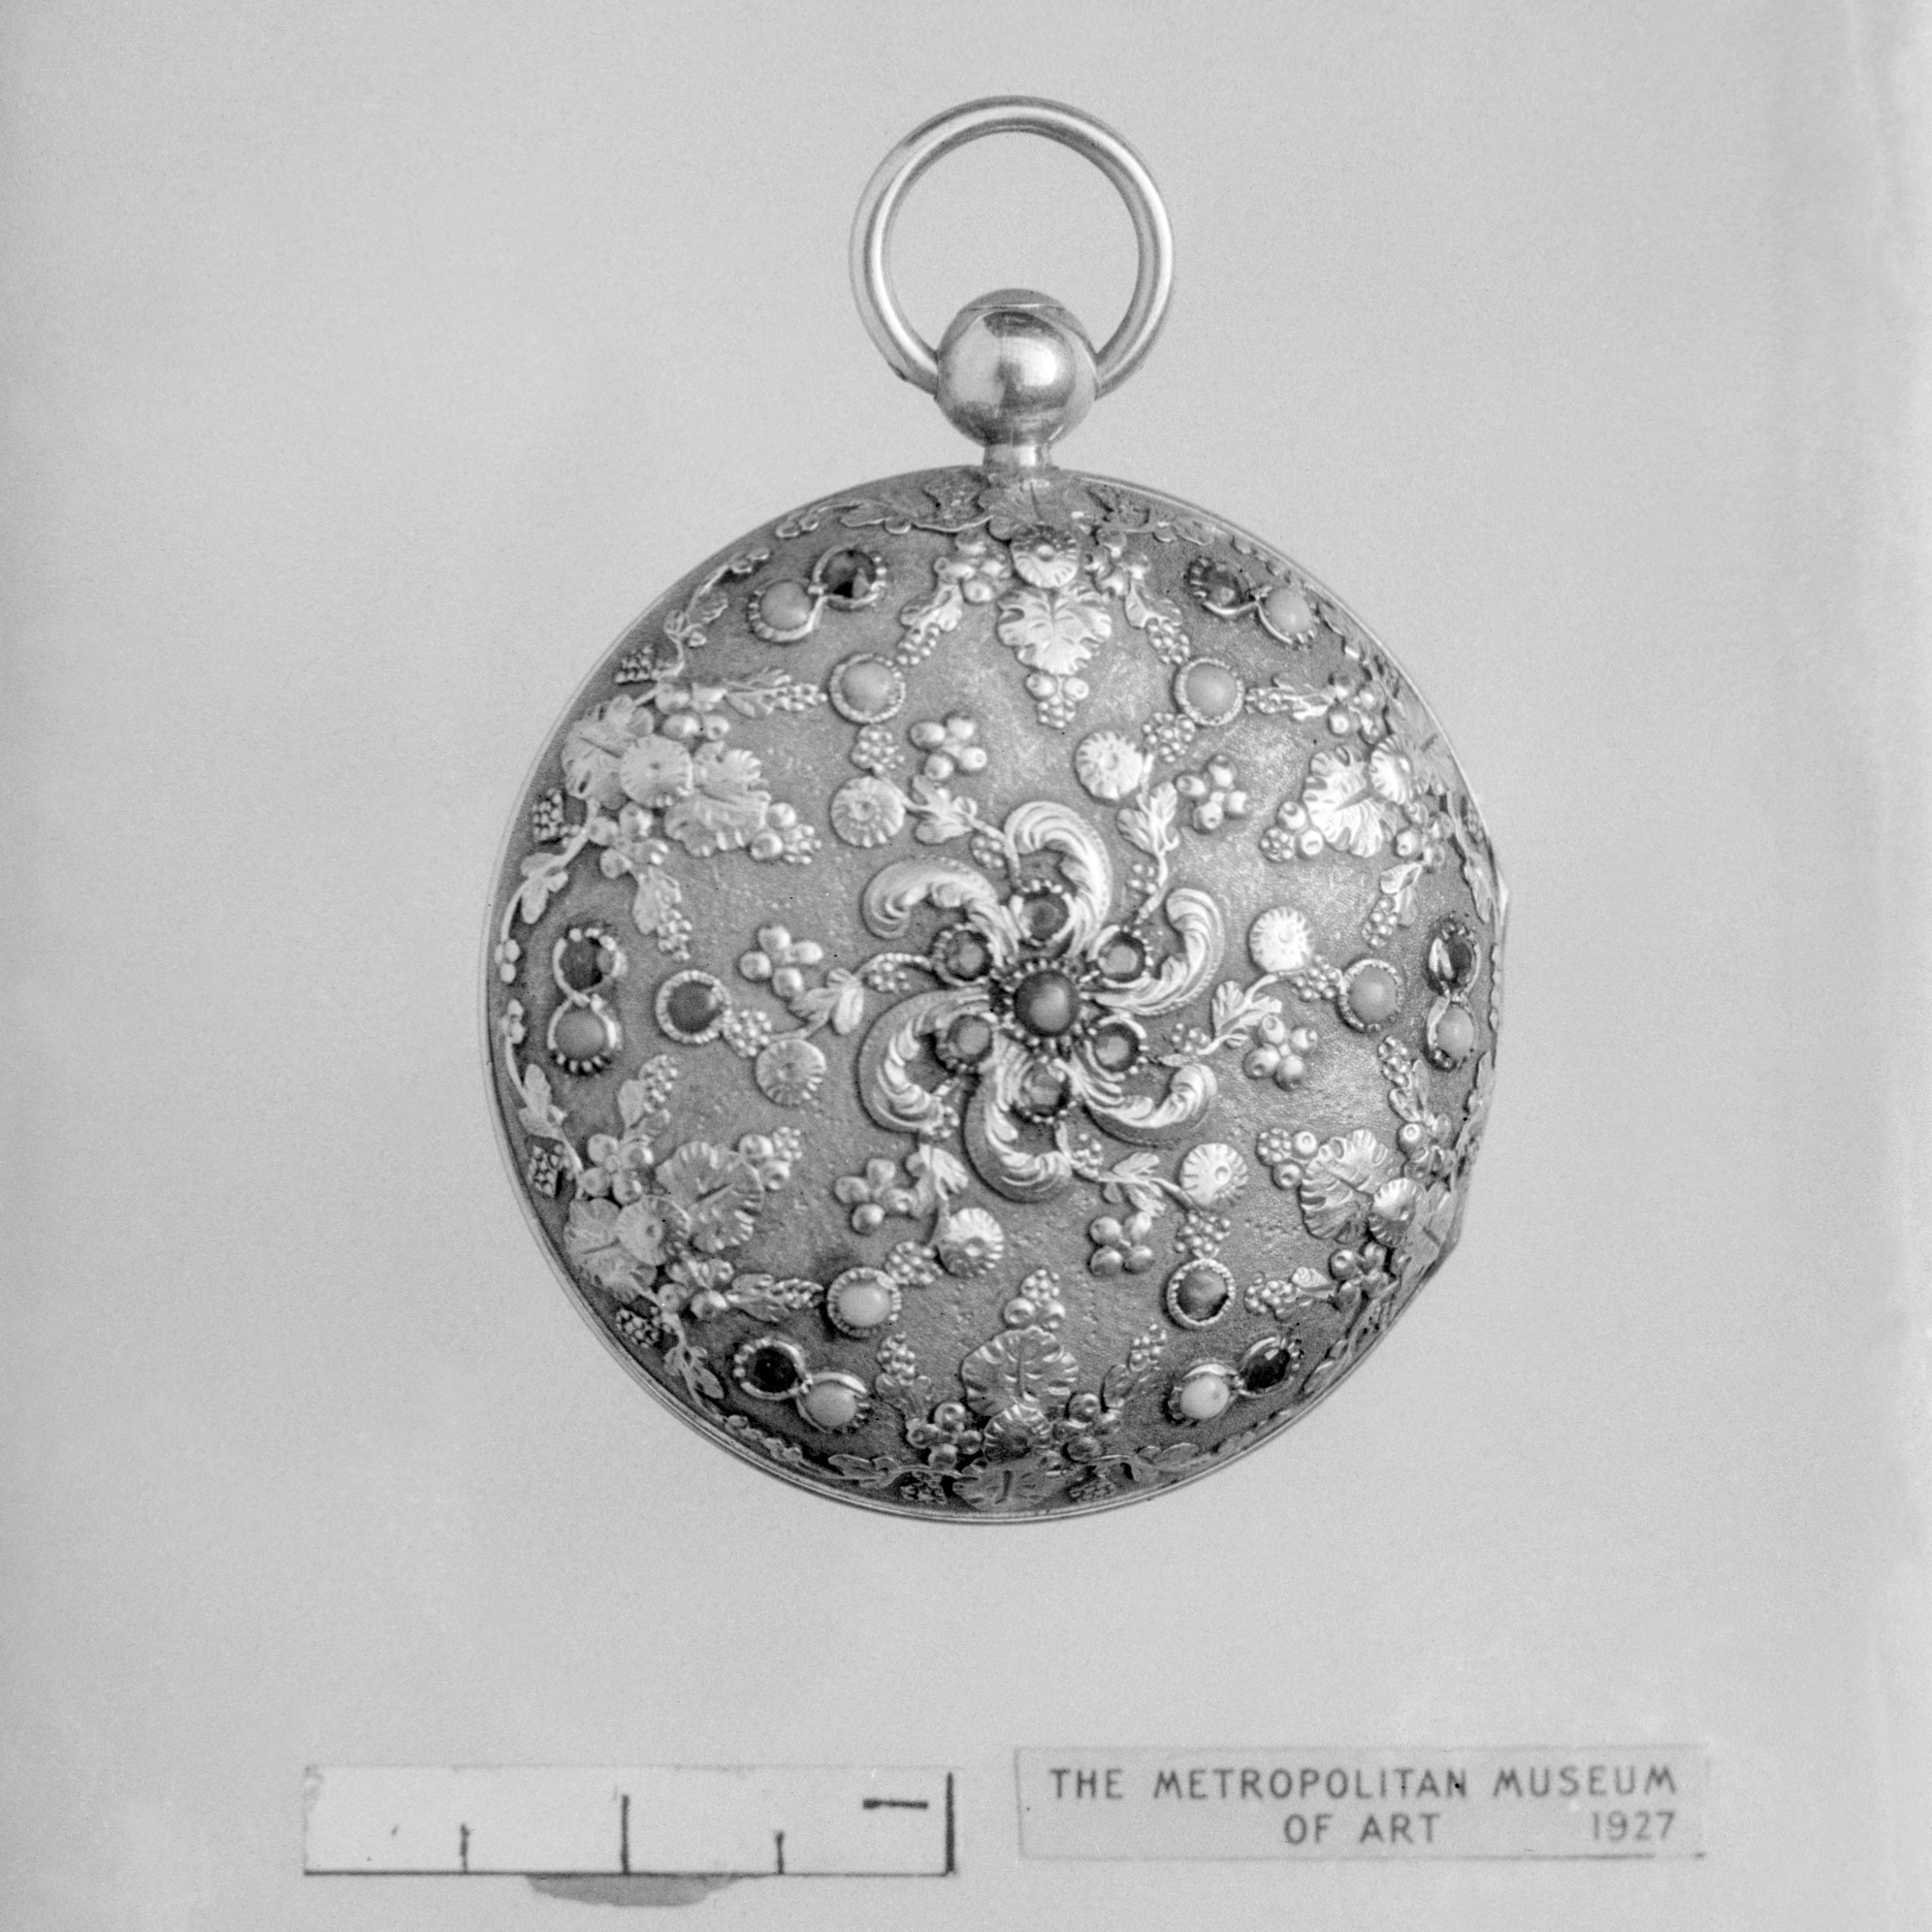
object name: watch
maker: c. moricand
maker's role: maker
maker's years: 1775-1875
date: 1815-1830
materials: enamel, gold, steel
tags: flowers